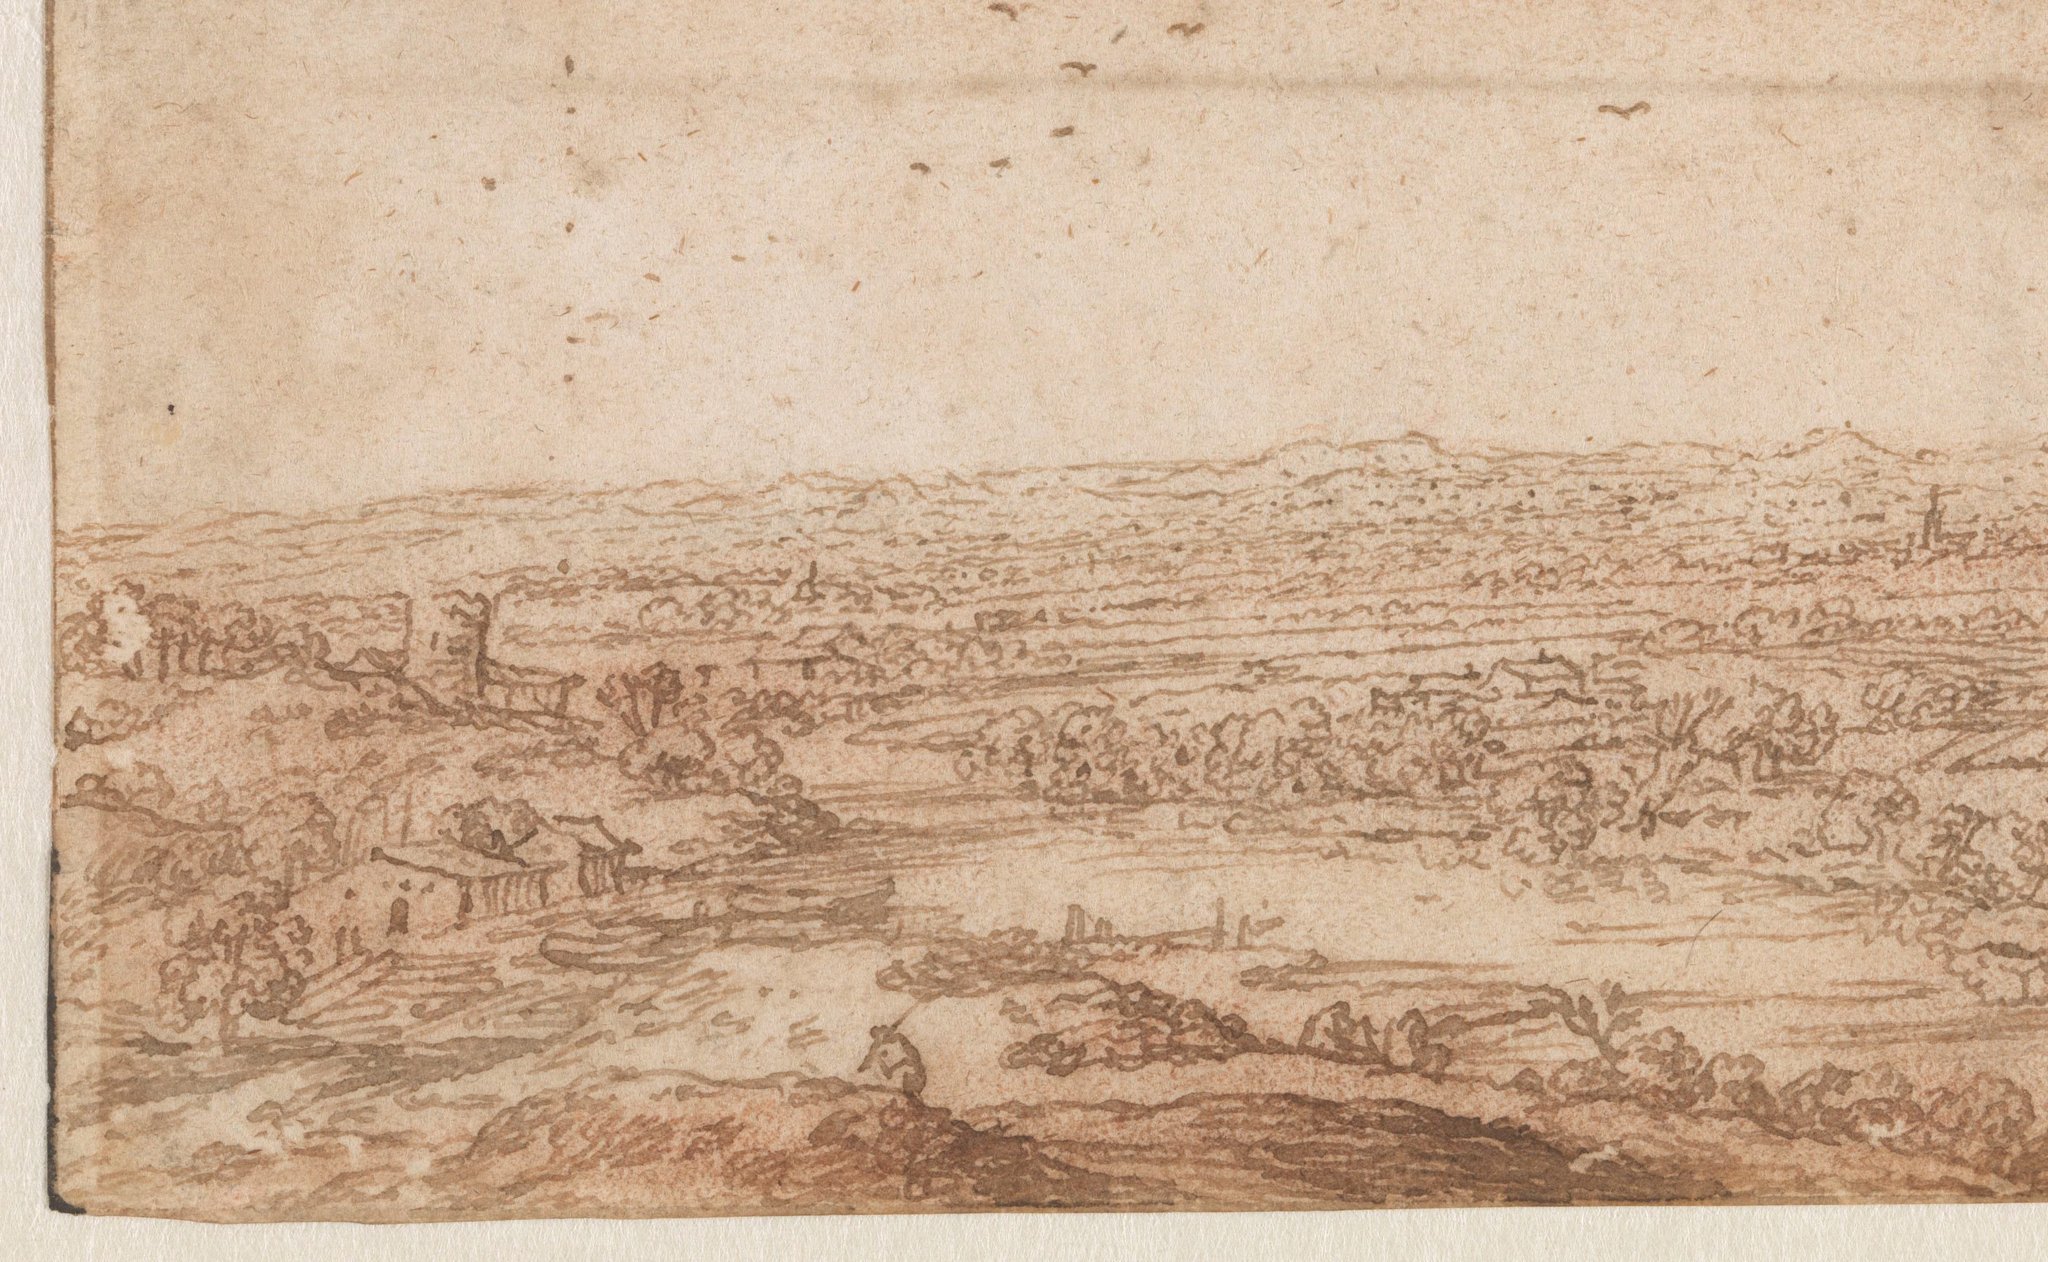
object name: drawing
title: Panoramic Landscape with River Logging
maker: jan ruyscher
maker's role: draughtsman, print maker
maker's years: 1625-1674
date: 1677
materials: chalk, paper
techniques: pen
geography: germany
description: Mogelijk onderdeel geweest van een schetsboek met landschapsstudies.